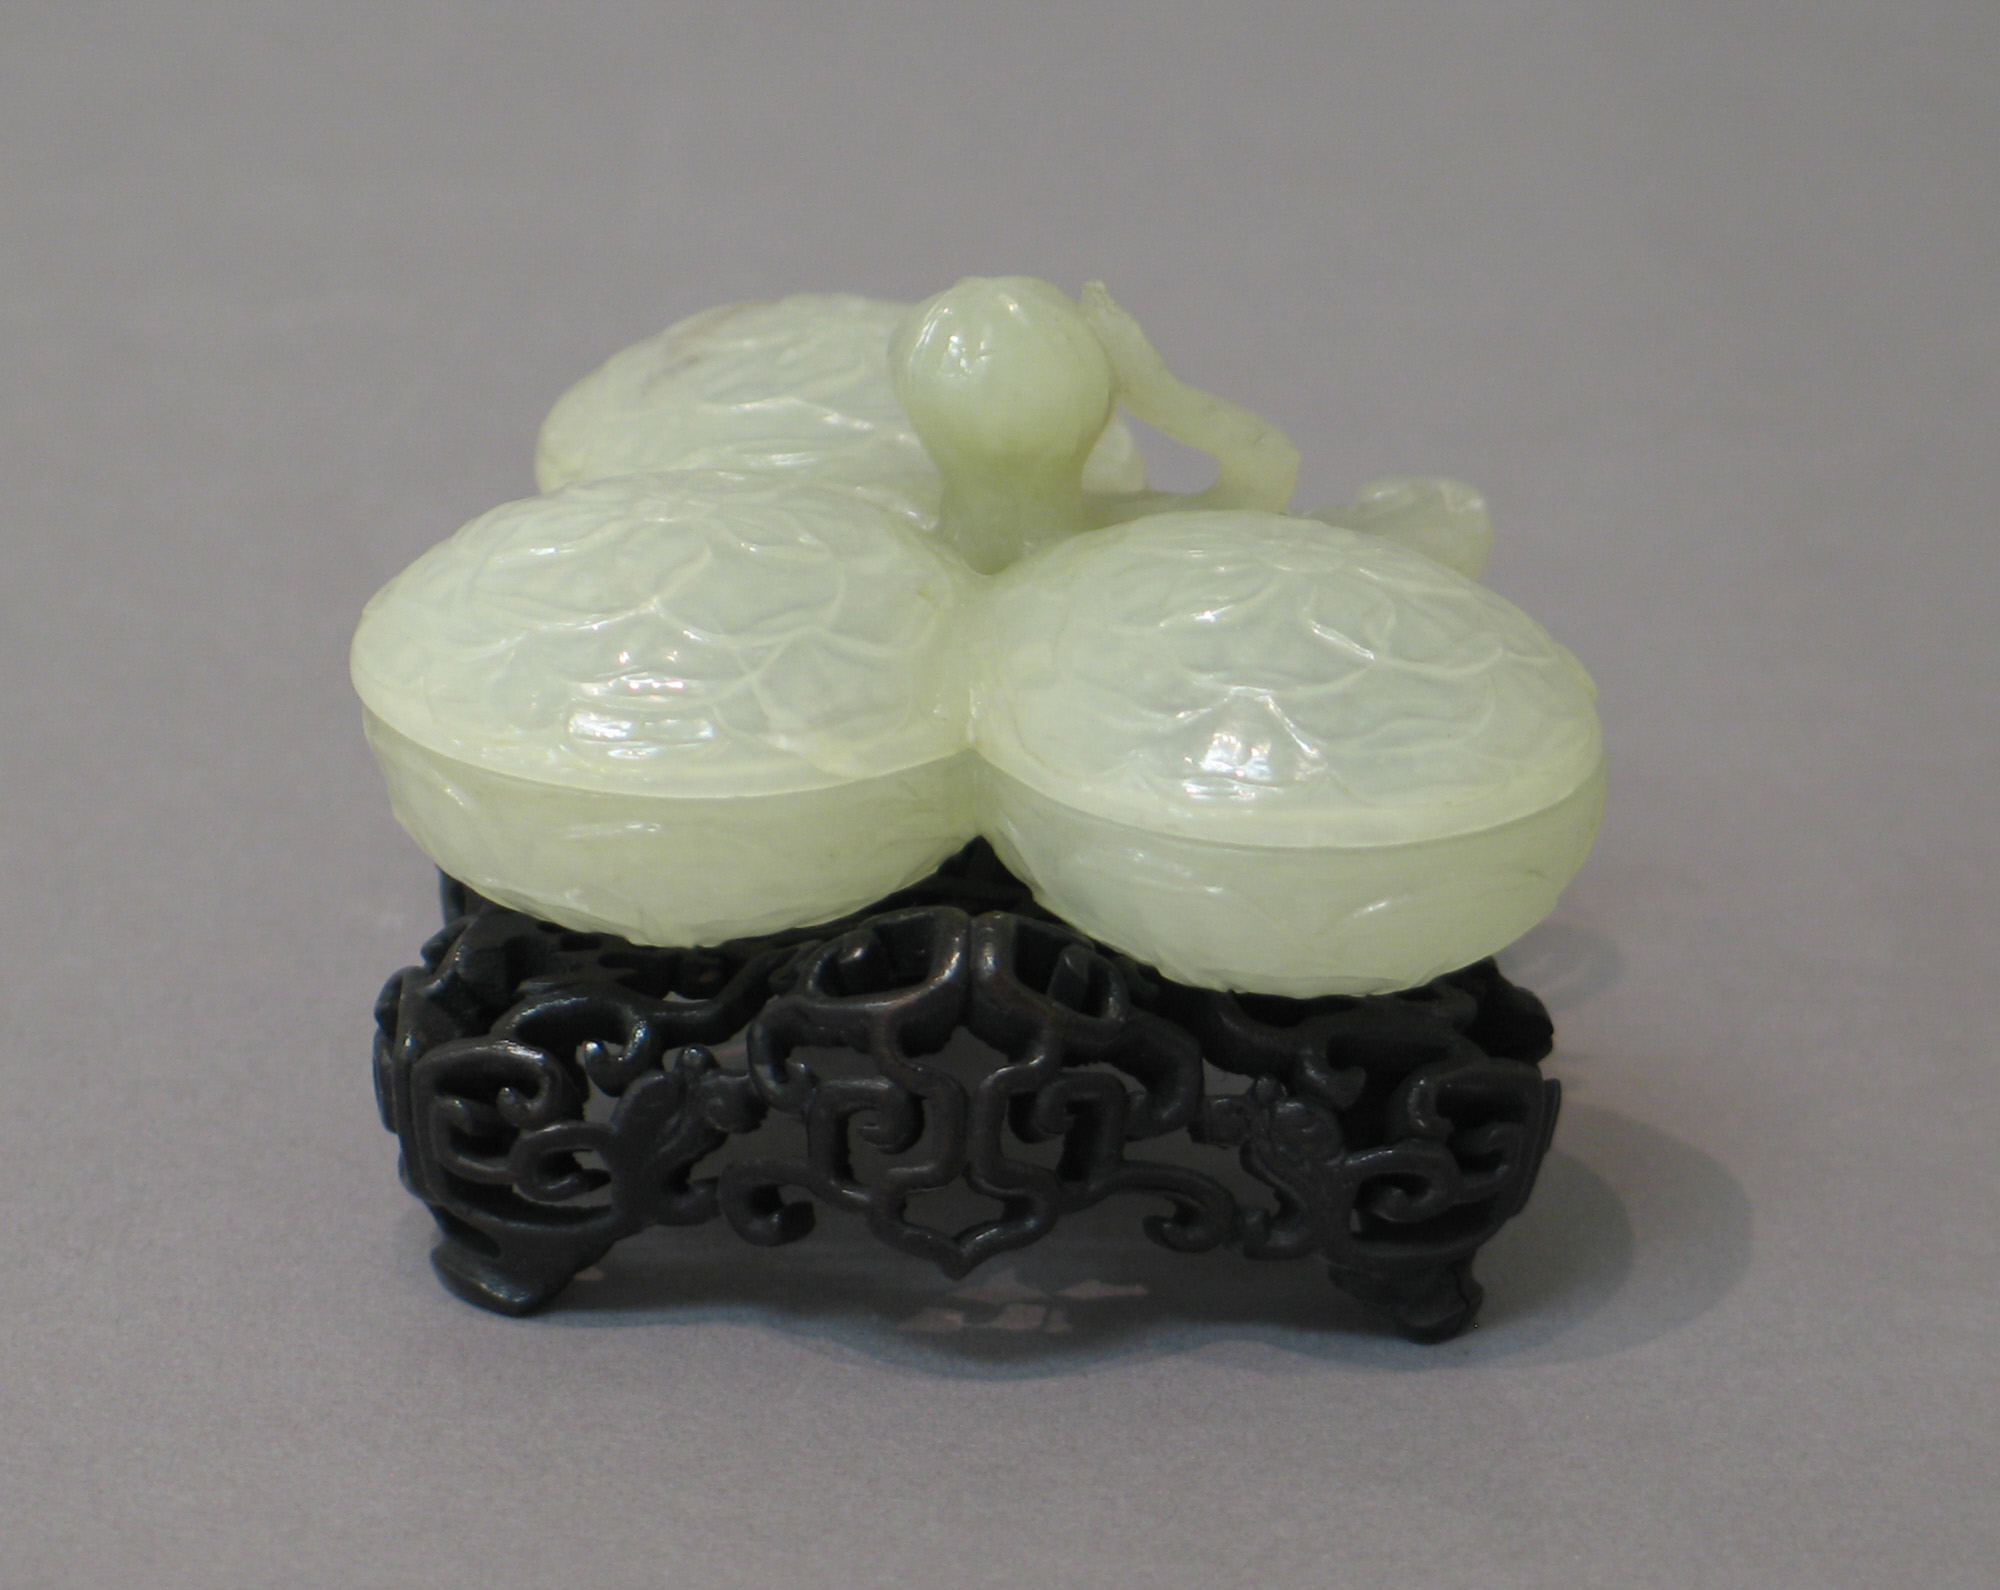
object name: box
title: Box with cover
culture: indian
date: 1701-1900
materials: jade